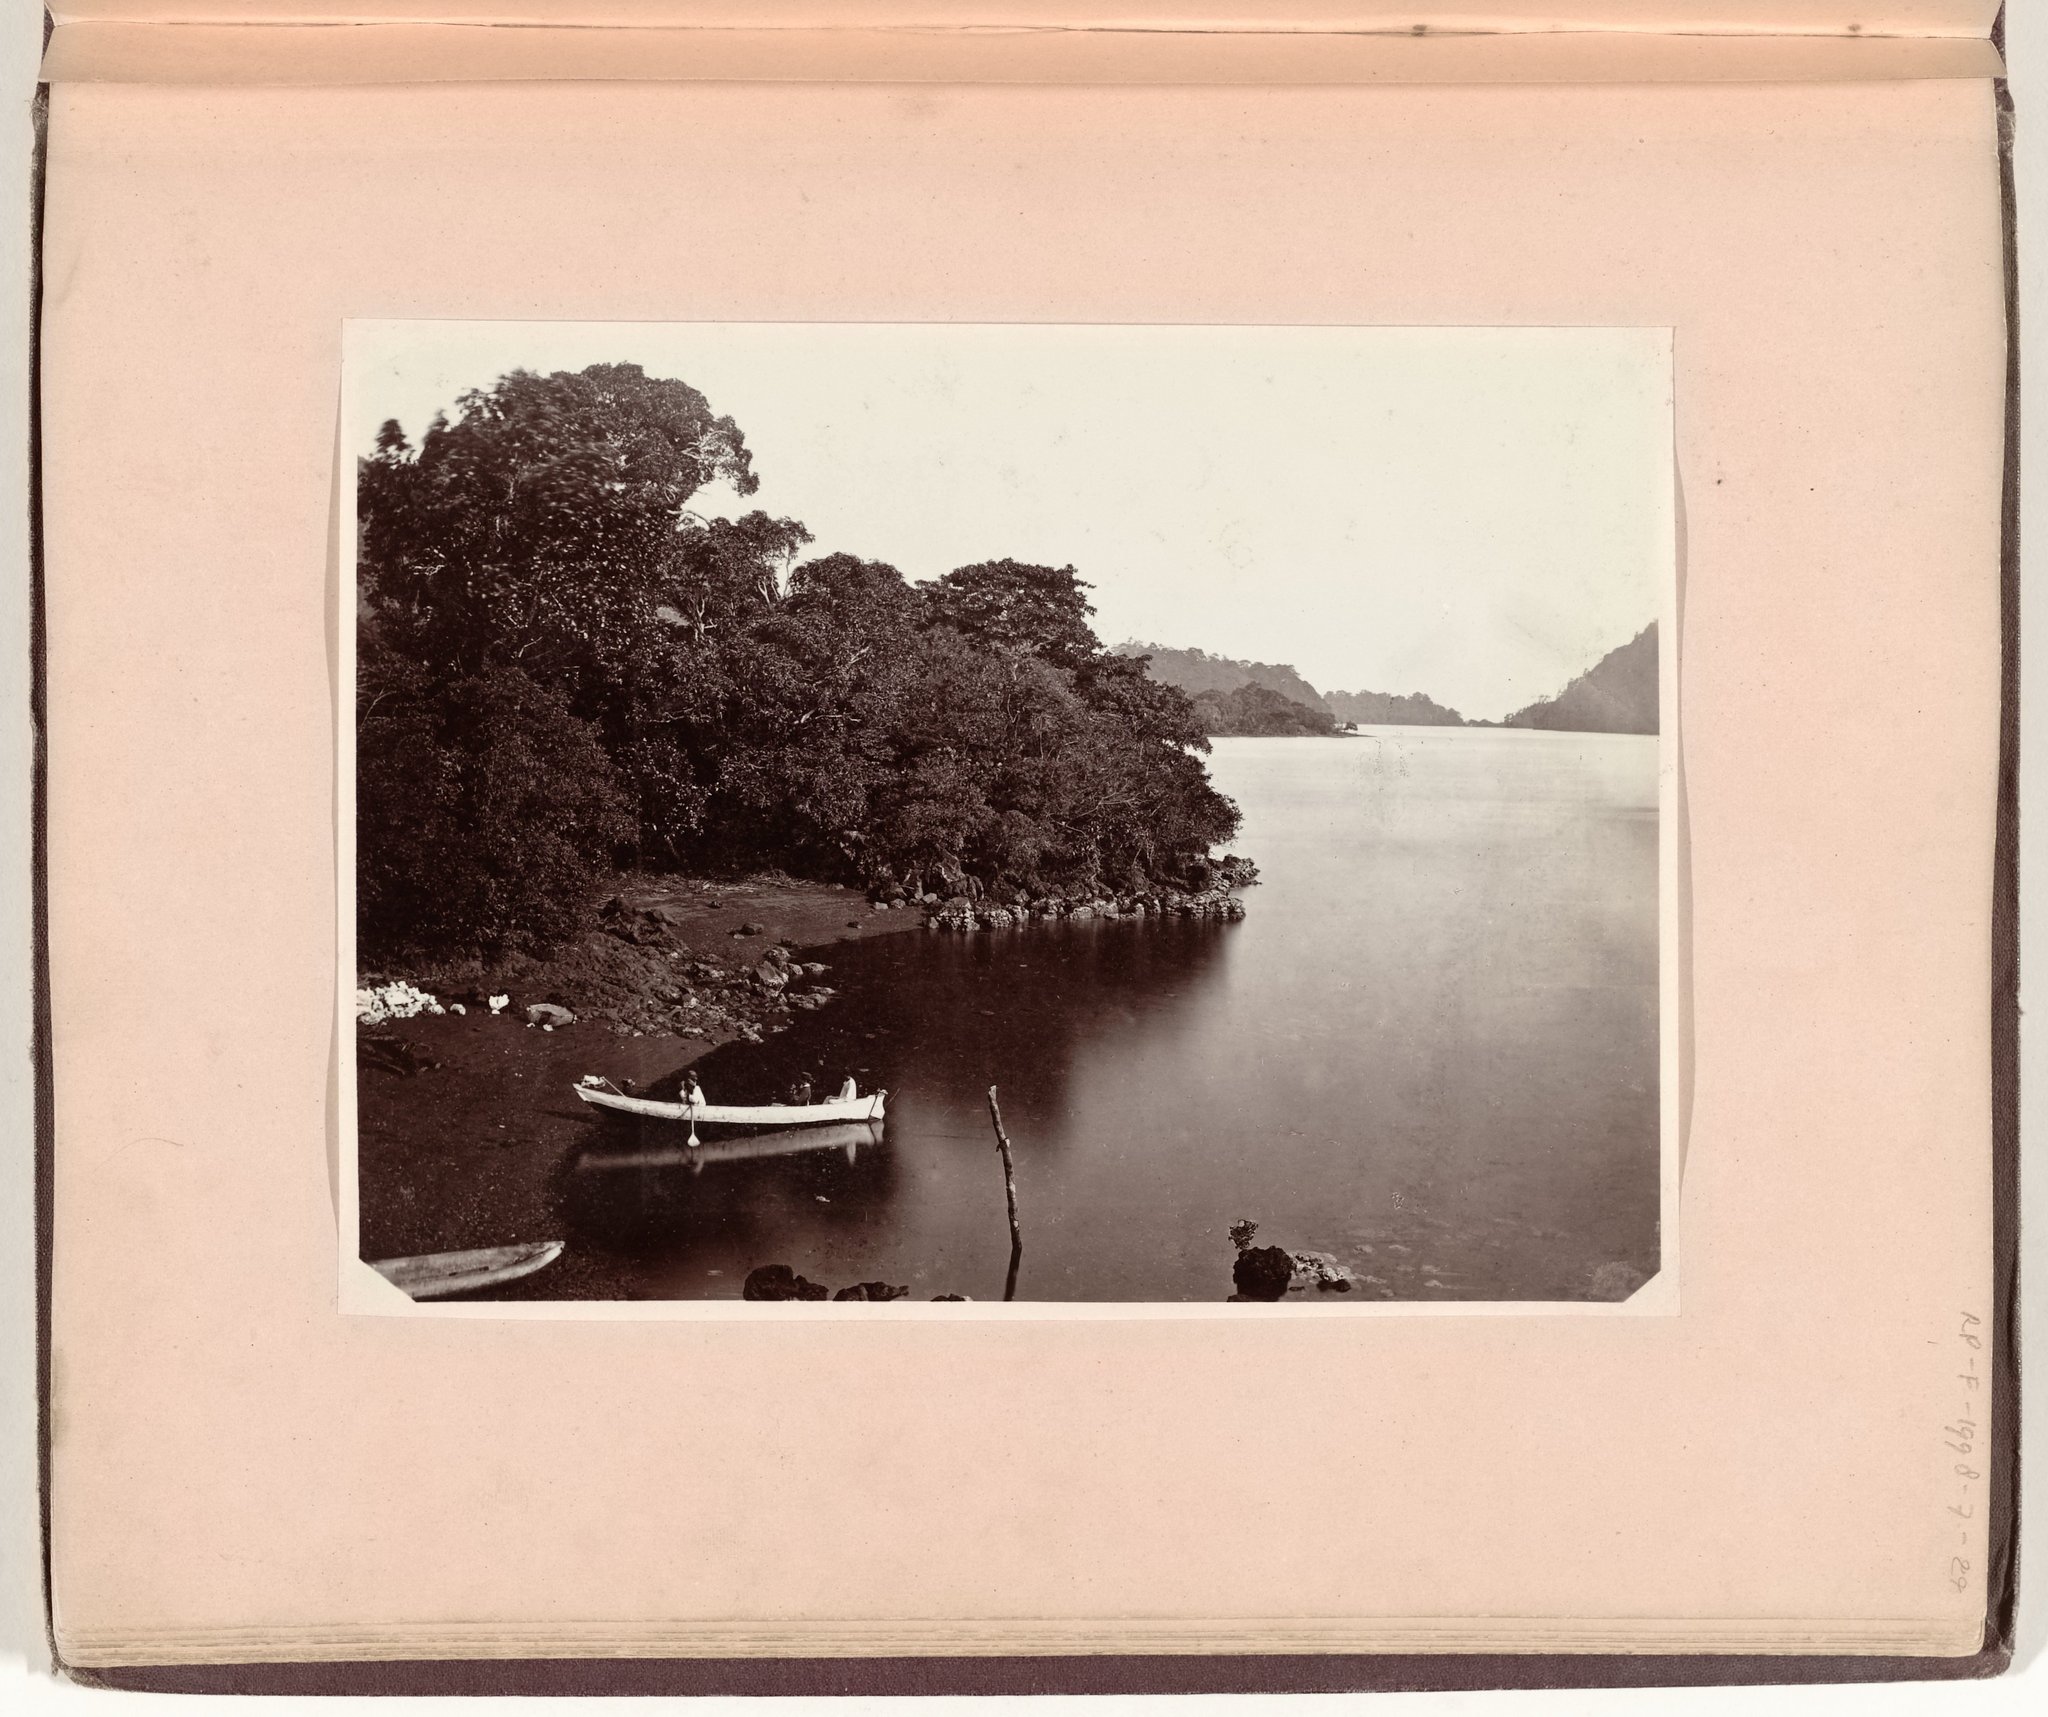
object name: album leaf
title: Gezicht op een baai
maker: c. dietrich (fotograaf)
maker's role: fotograaf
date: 1875-1890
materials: cardboard, paper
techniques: albumen print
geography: banda islands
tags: gulf, bay